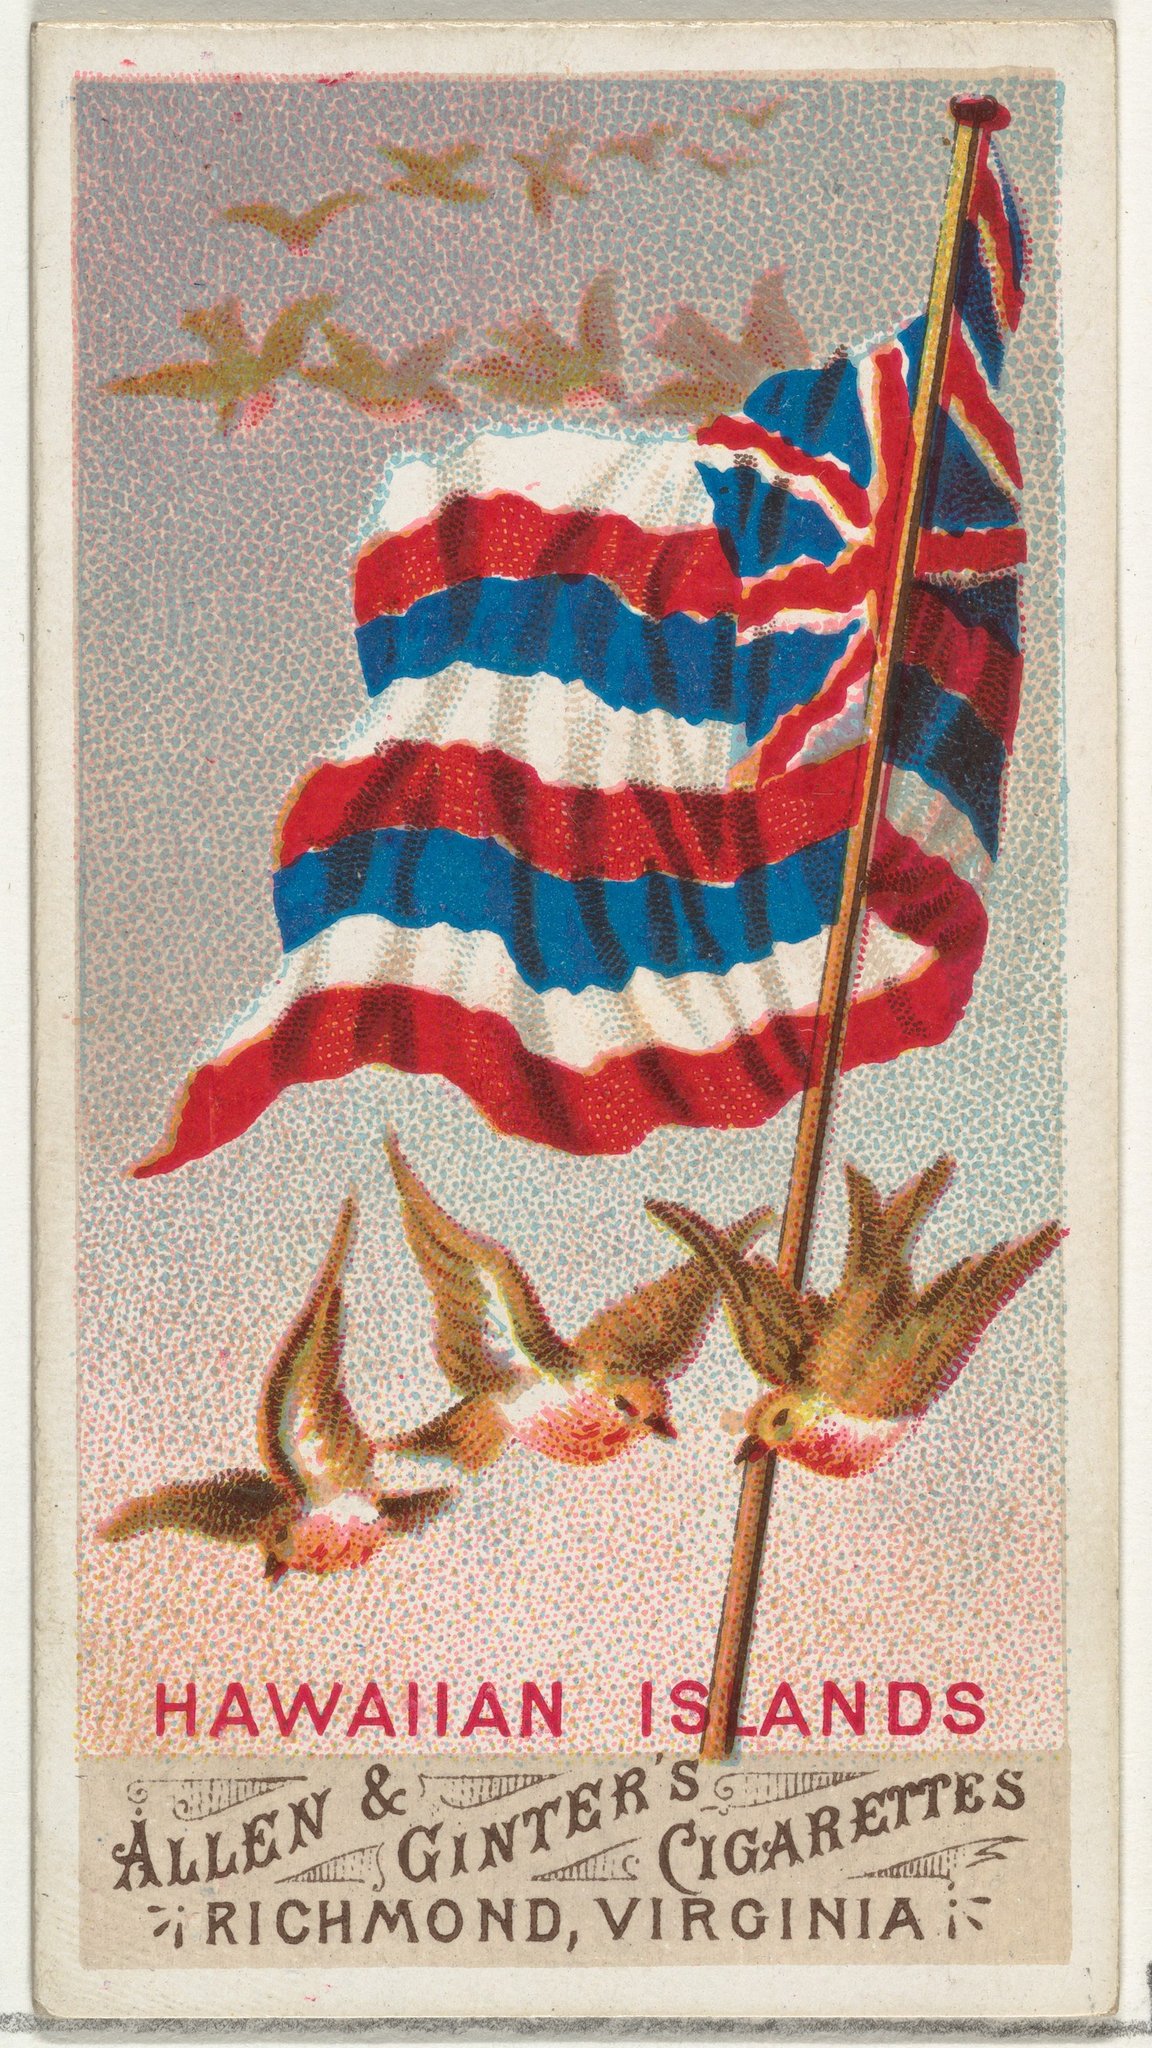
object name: print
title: Hawaiian Islands, from Flags of All Nations, Series 1 (N9) for Allen & Ginter Cigarettes Brands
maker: allen & ginter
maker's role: publisher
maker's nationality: american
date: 1887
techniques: color lithograph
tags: flags